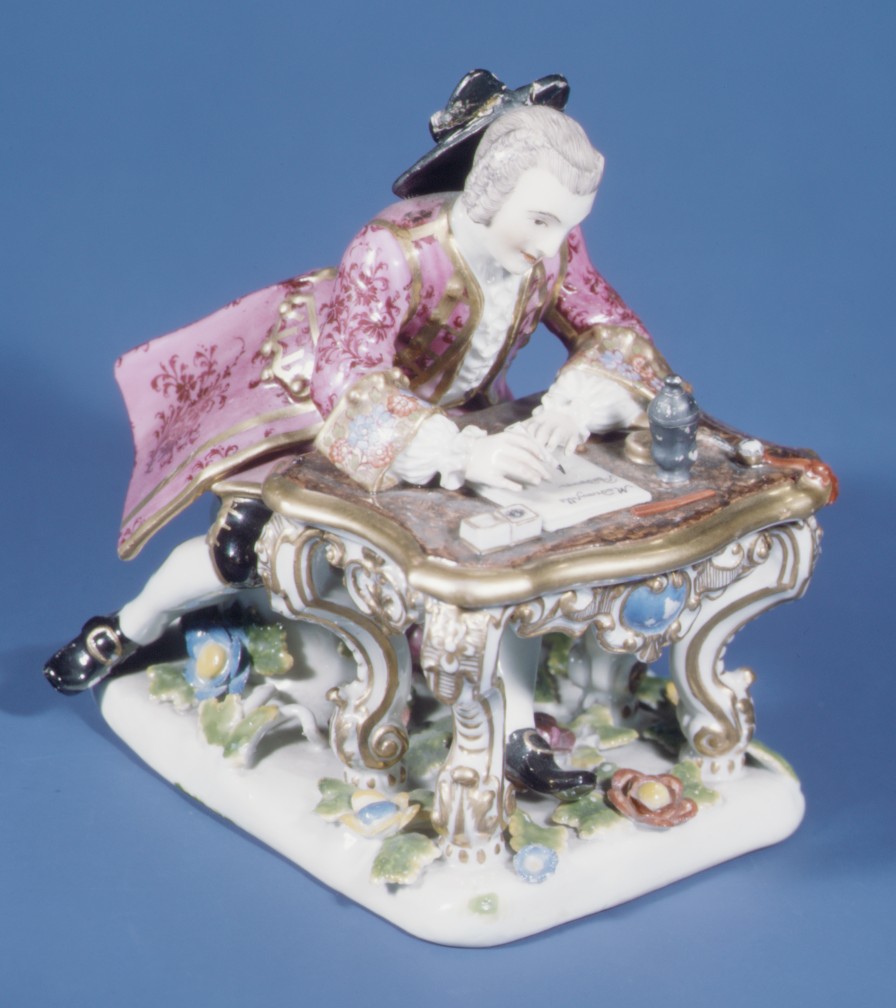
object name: figure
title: Letter writer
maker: meissen manufactory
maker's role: manufactory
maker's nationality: german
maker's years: 1710-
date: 1740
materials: hard paste porcelain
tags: men,writing,desks